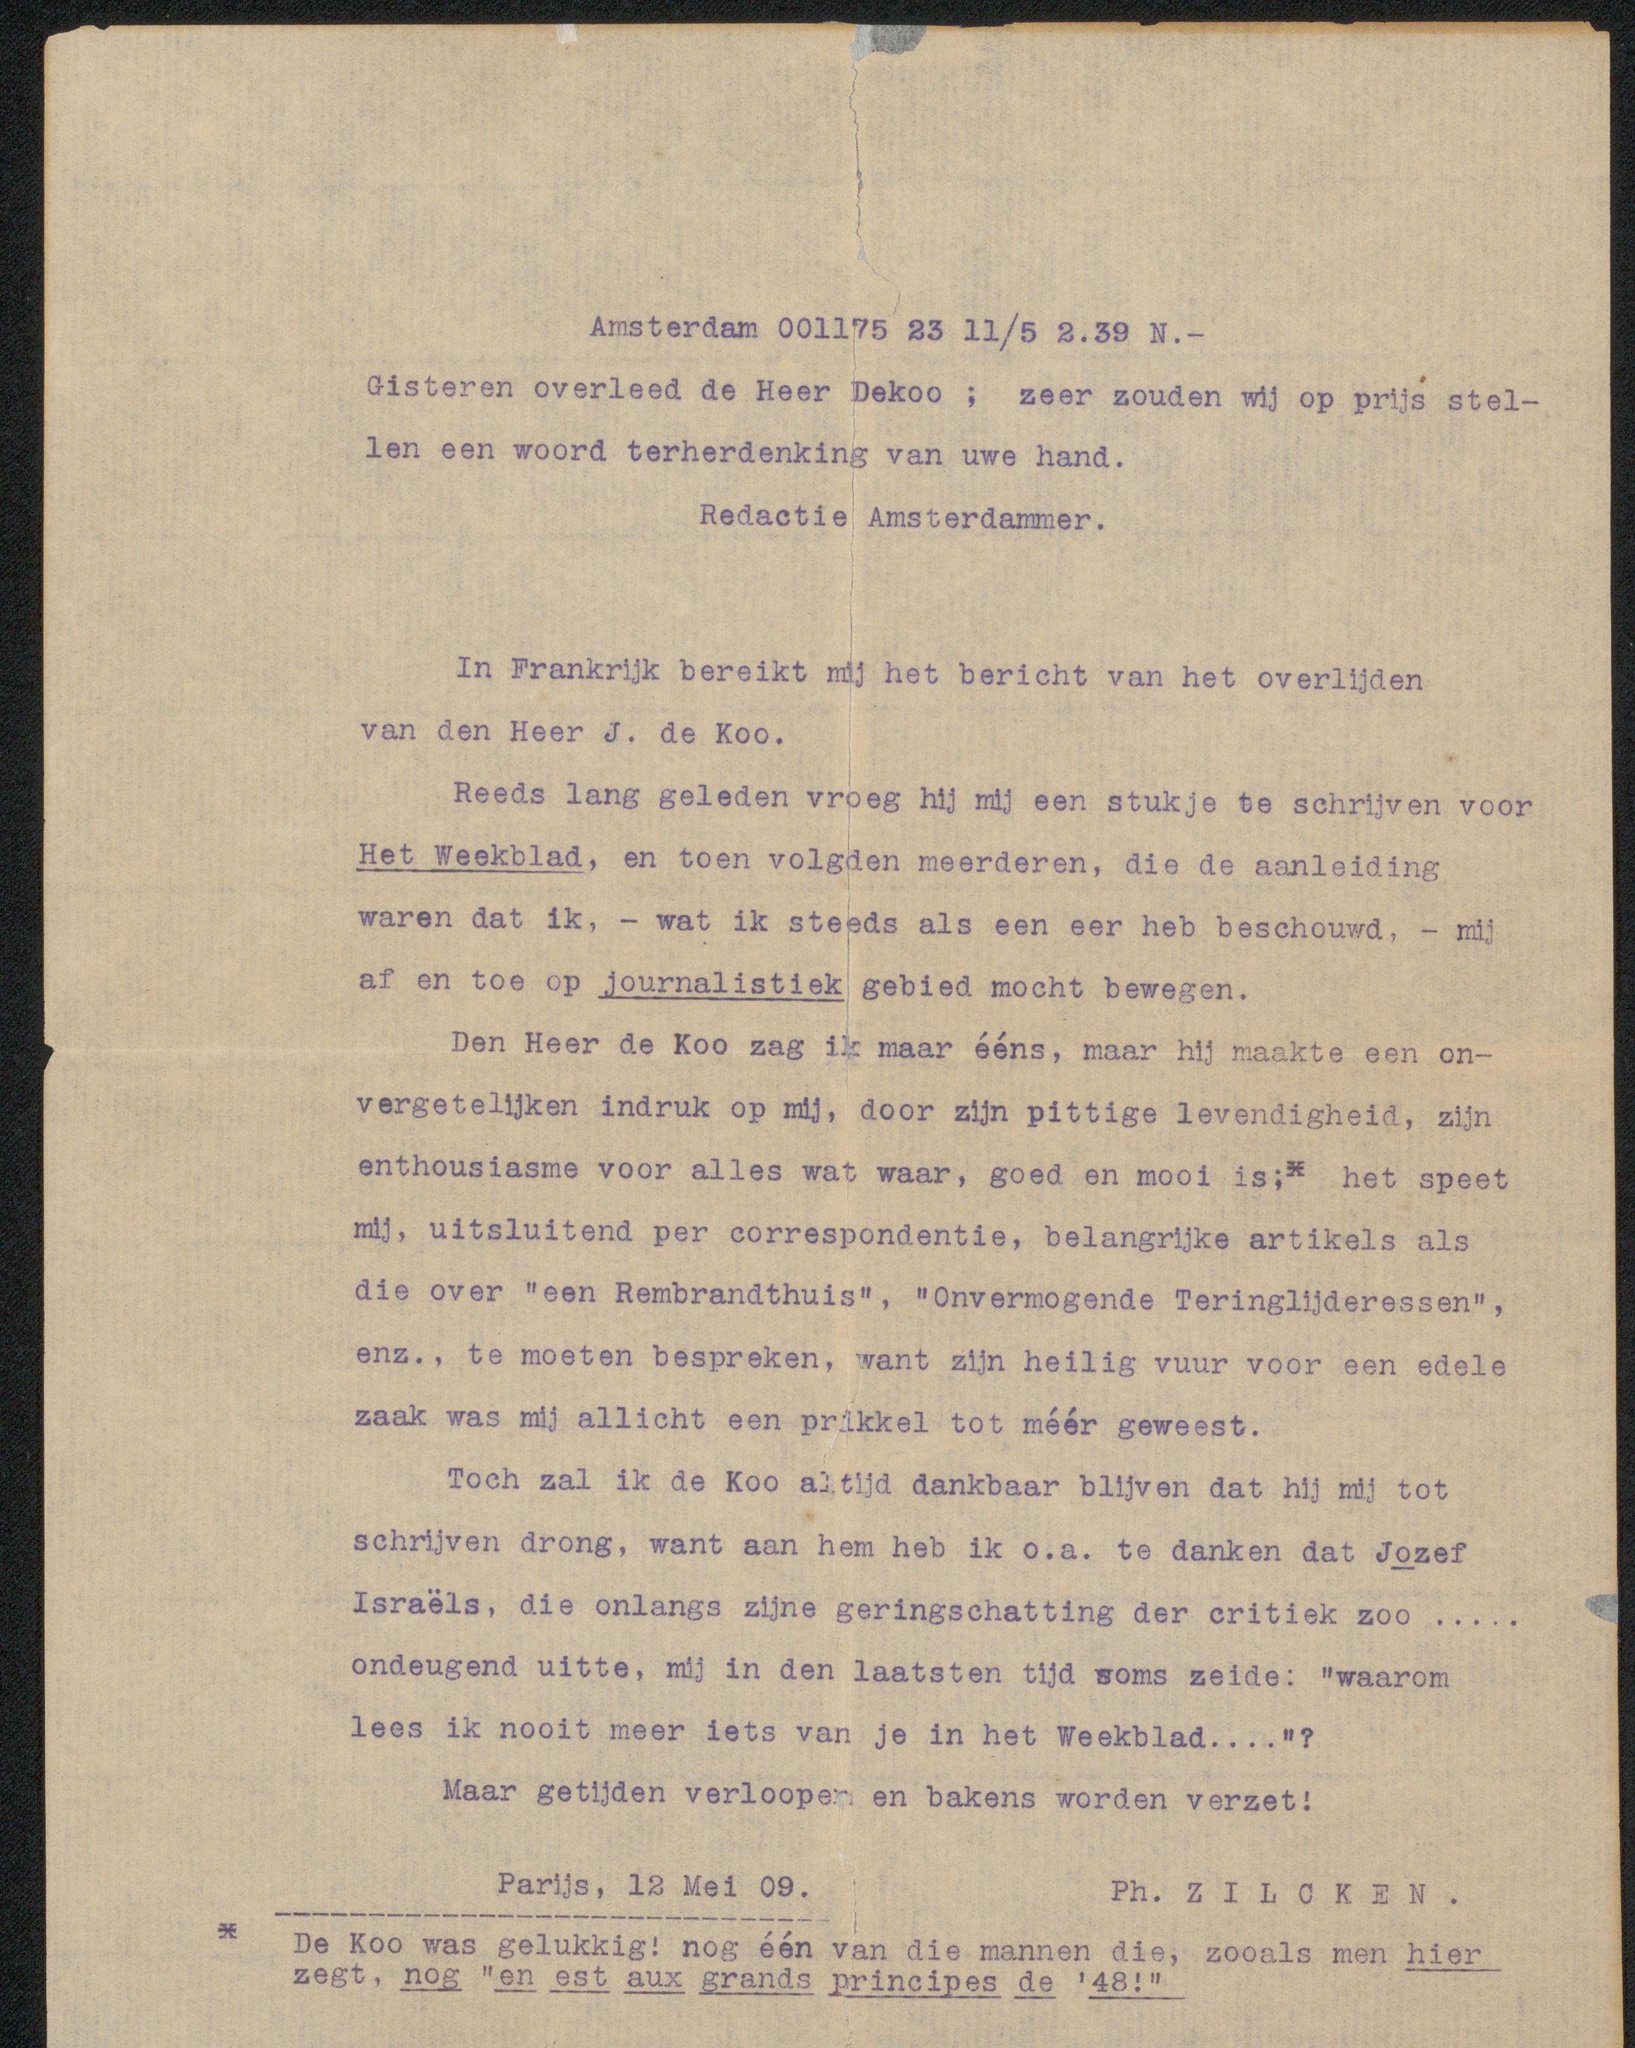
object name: tekst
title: In memoriam Johannes de Koo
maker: philip zilcken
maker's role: draughtsman, painter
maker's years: 1857-1930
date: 1909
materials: ink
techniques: pen, typewriting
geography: paris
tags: johannes de koo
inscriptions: collector's mark: ‘RPK’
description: Transcriptie van RP-D-1982-43-DEKOO(J.)-50B1.